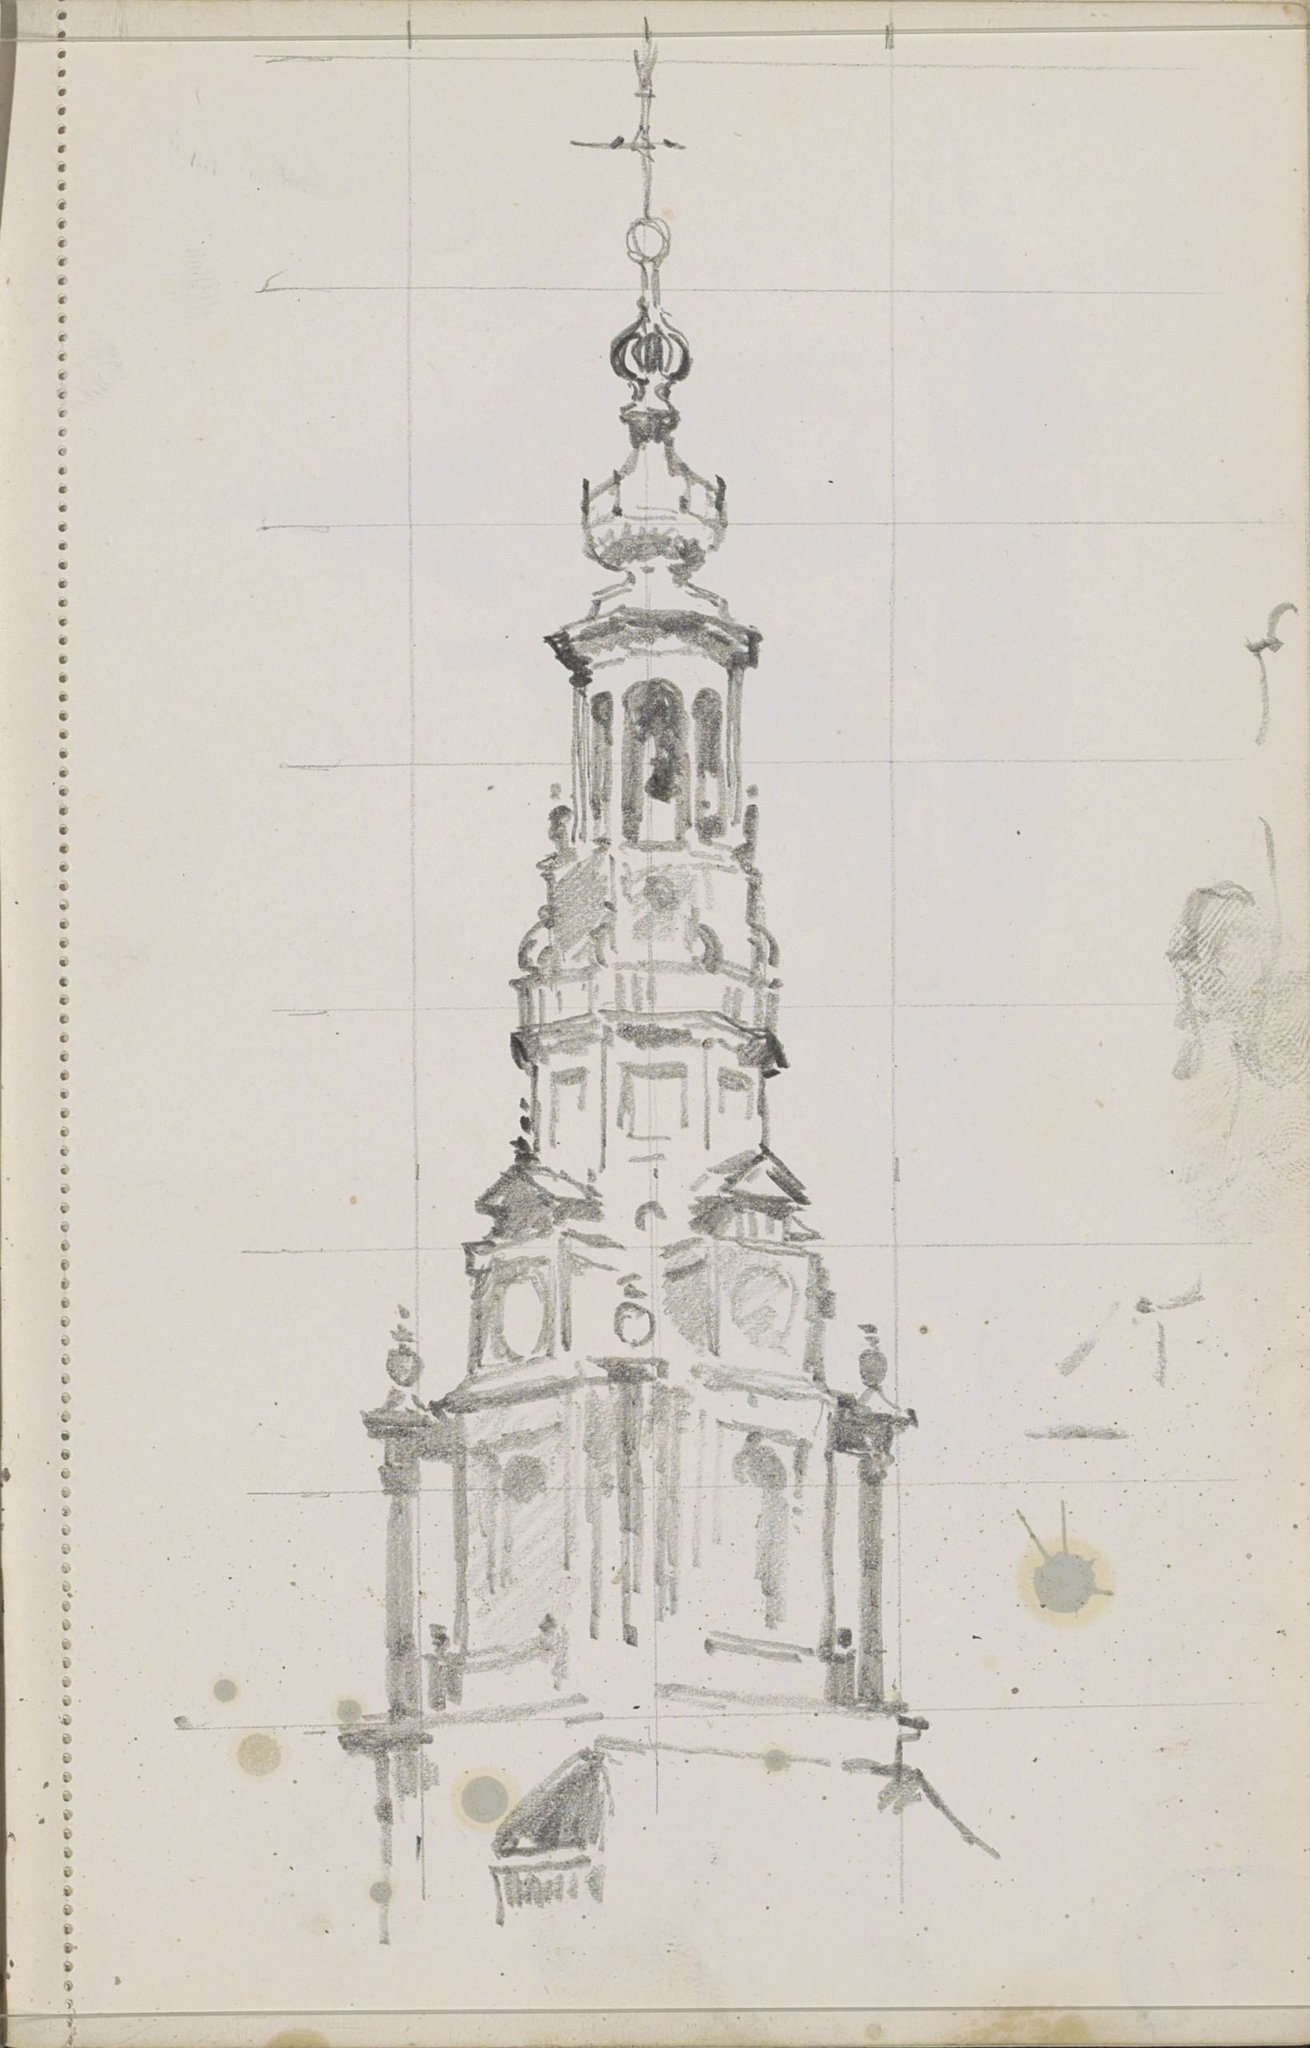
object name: sketchbook leaf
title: Kerktoren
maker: cornelis vreedenburgh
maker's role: draughtsman, print maker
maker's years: 1880-1946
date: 1890-1946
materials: paper, pencil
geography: amsterdam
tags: parts of church exterior and annexes: tower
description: Blad 28 recto uit een schetsboek met 53 bladen.